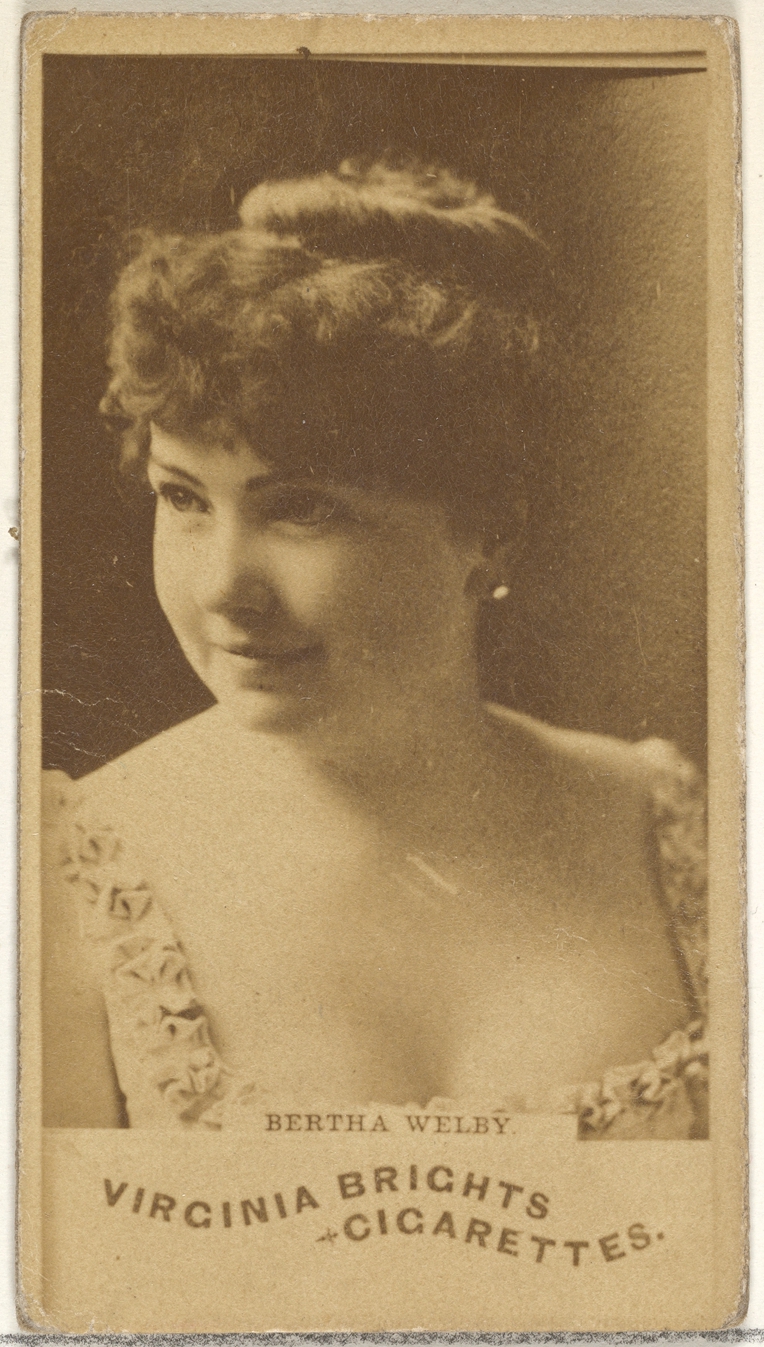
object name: photograph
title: Bertha Welby, from the Actors and Actresses series (N45, Type 1) for Virginia Brights Cigarettes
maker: allen & ginter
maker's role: publisher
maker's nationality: american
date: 1888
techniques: albumen silver print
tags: portraits,women,actresses